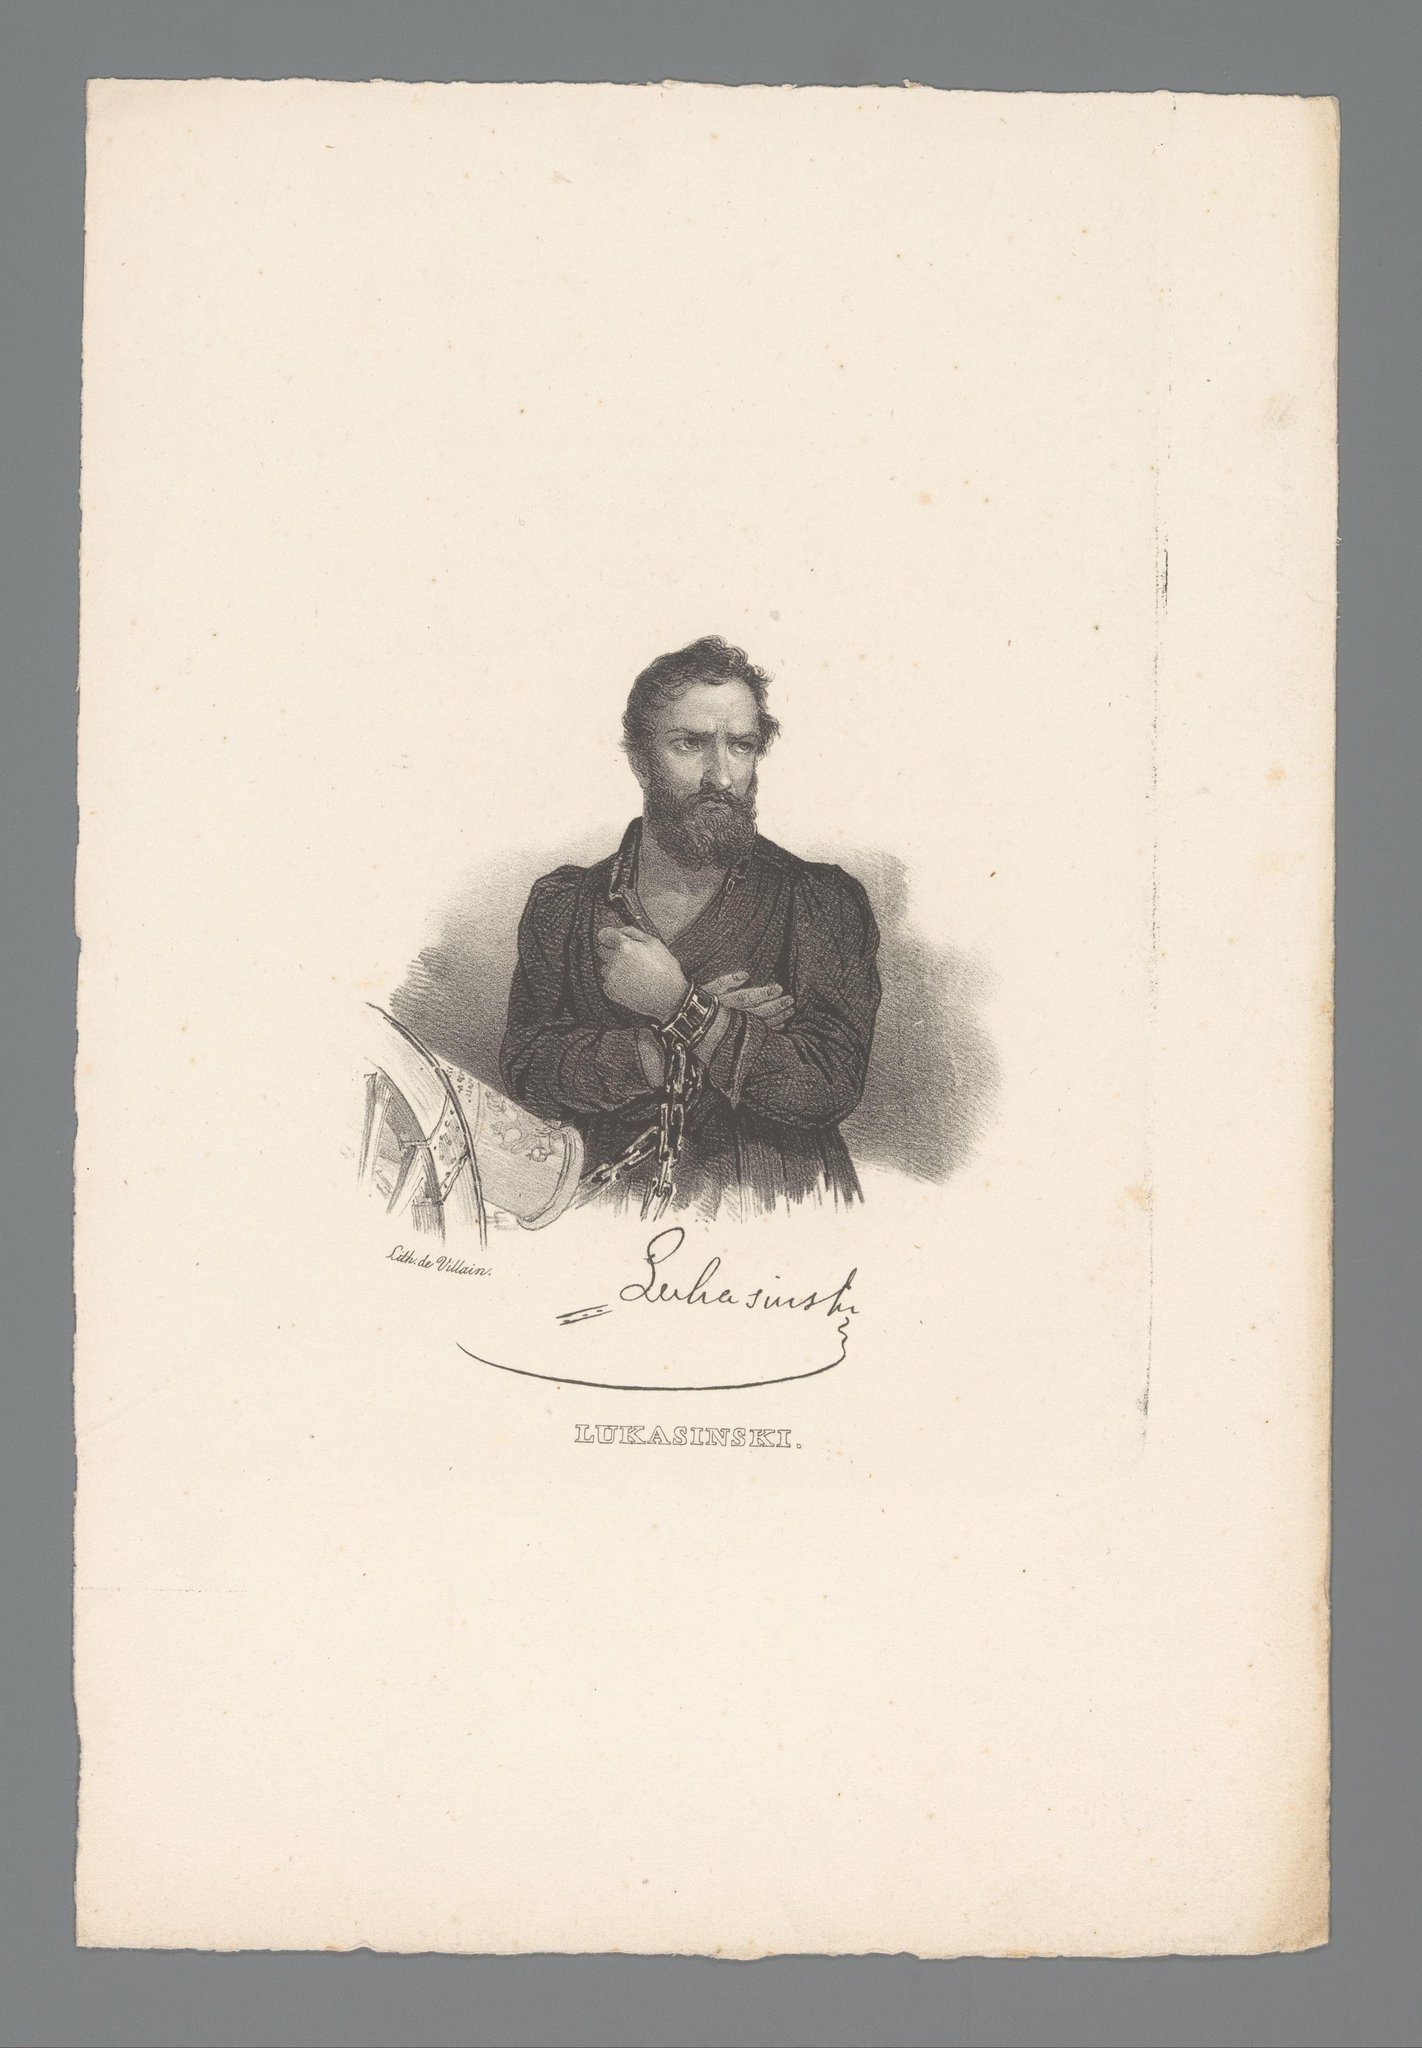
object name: book illustration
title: Lukasinski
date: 1832-1839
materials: paper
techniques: lithograph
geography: paris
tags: historical persons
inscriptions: collector's mark: Lugt 2228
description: Prent uit: Straszewicz., Joseph. Les polonais et les polonaises de la révolution du 29 novembre 1830, ou Portraits des personnes qui ont figuré dans la dernière guerre de l'indépendance polonaise, avec les fac-simile de leur signature, lithographiés sur dessins originaux, par les artistes les plus distingués: MM. Grévedon, Maurin, Vigneron, Belliard, Devéria, Bazin, Desmadryl, Lecler, Desmaisons, Rutowski, officier polonais, etc,. etc., accompagnés d'une biographie pour chaque portrait. Parijs: Catherine-Anaïs Pinard, 1832. Of uit: Straszewicz., Joseph. Les polonais et les polonaises de la révolution du 29 novembre 1830. Biographie des personnes qui ont figuré dans la dernière guerre de l'indépendance polonaise, avec les fac-simile de leur signature, ornée de 30 portraits lithographiés sur dessins originaux, par les artistes les plus distingués: MM. Grévedon, Maurin, Vigneron, Belliard, Devéria, Bazin, Desmadryl, Lecler, etc., etc.. Parijs: s.n., 1839.